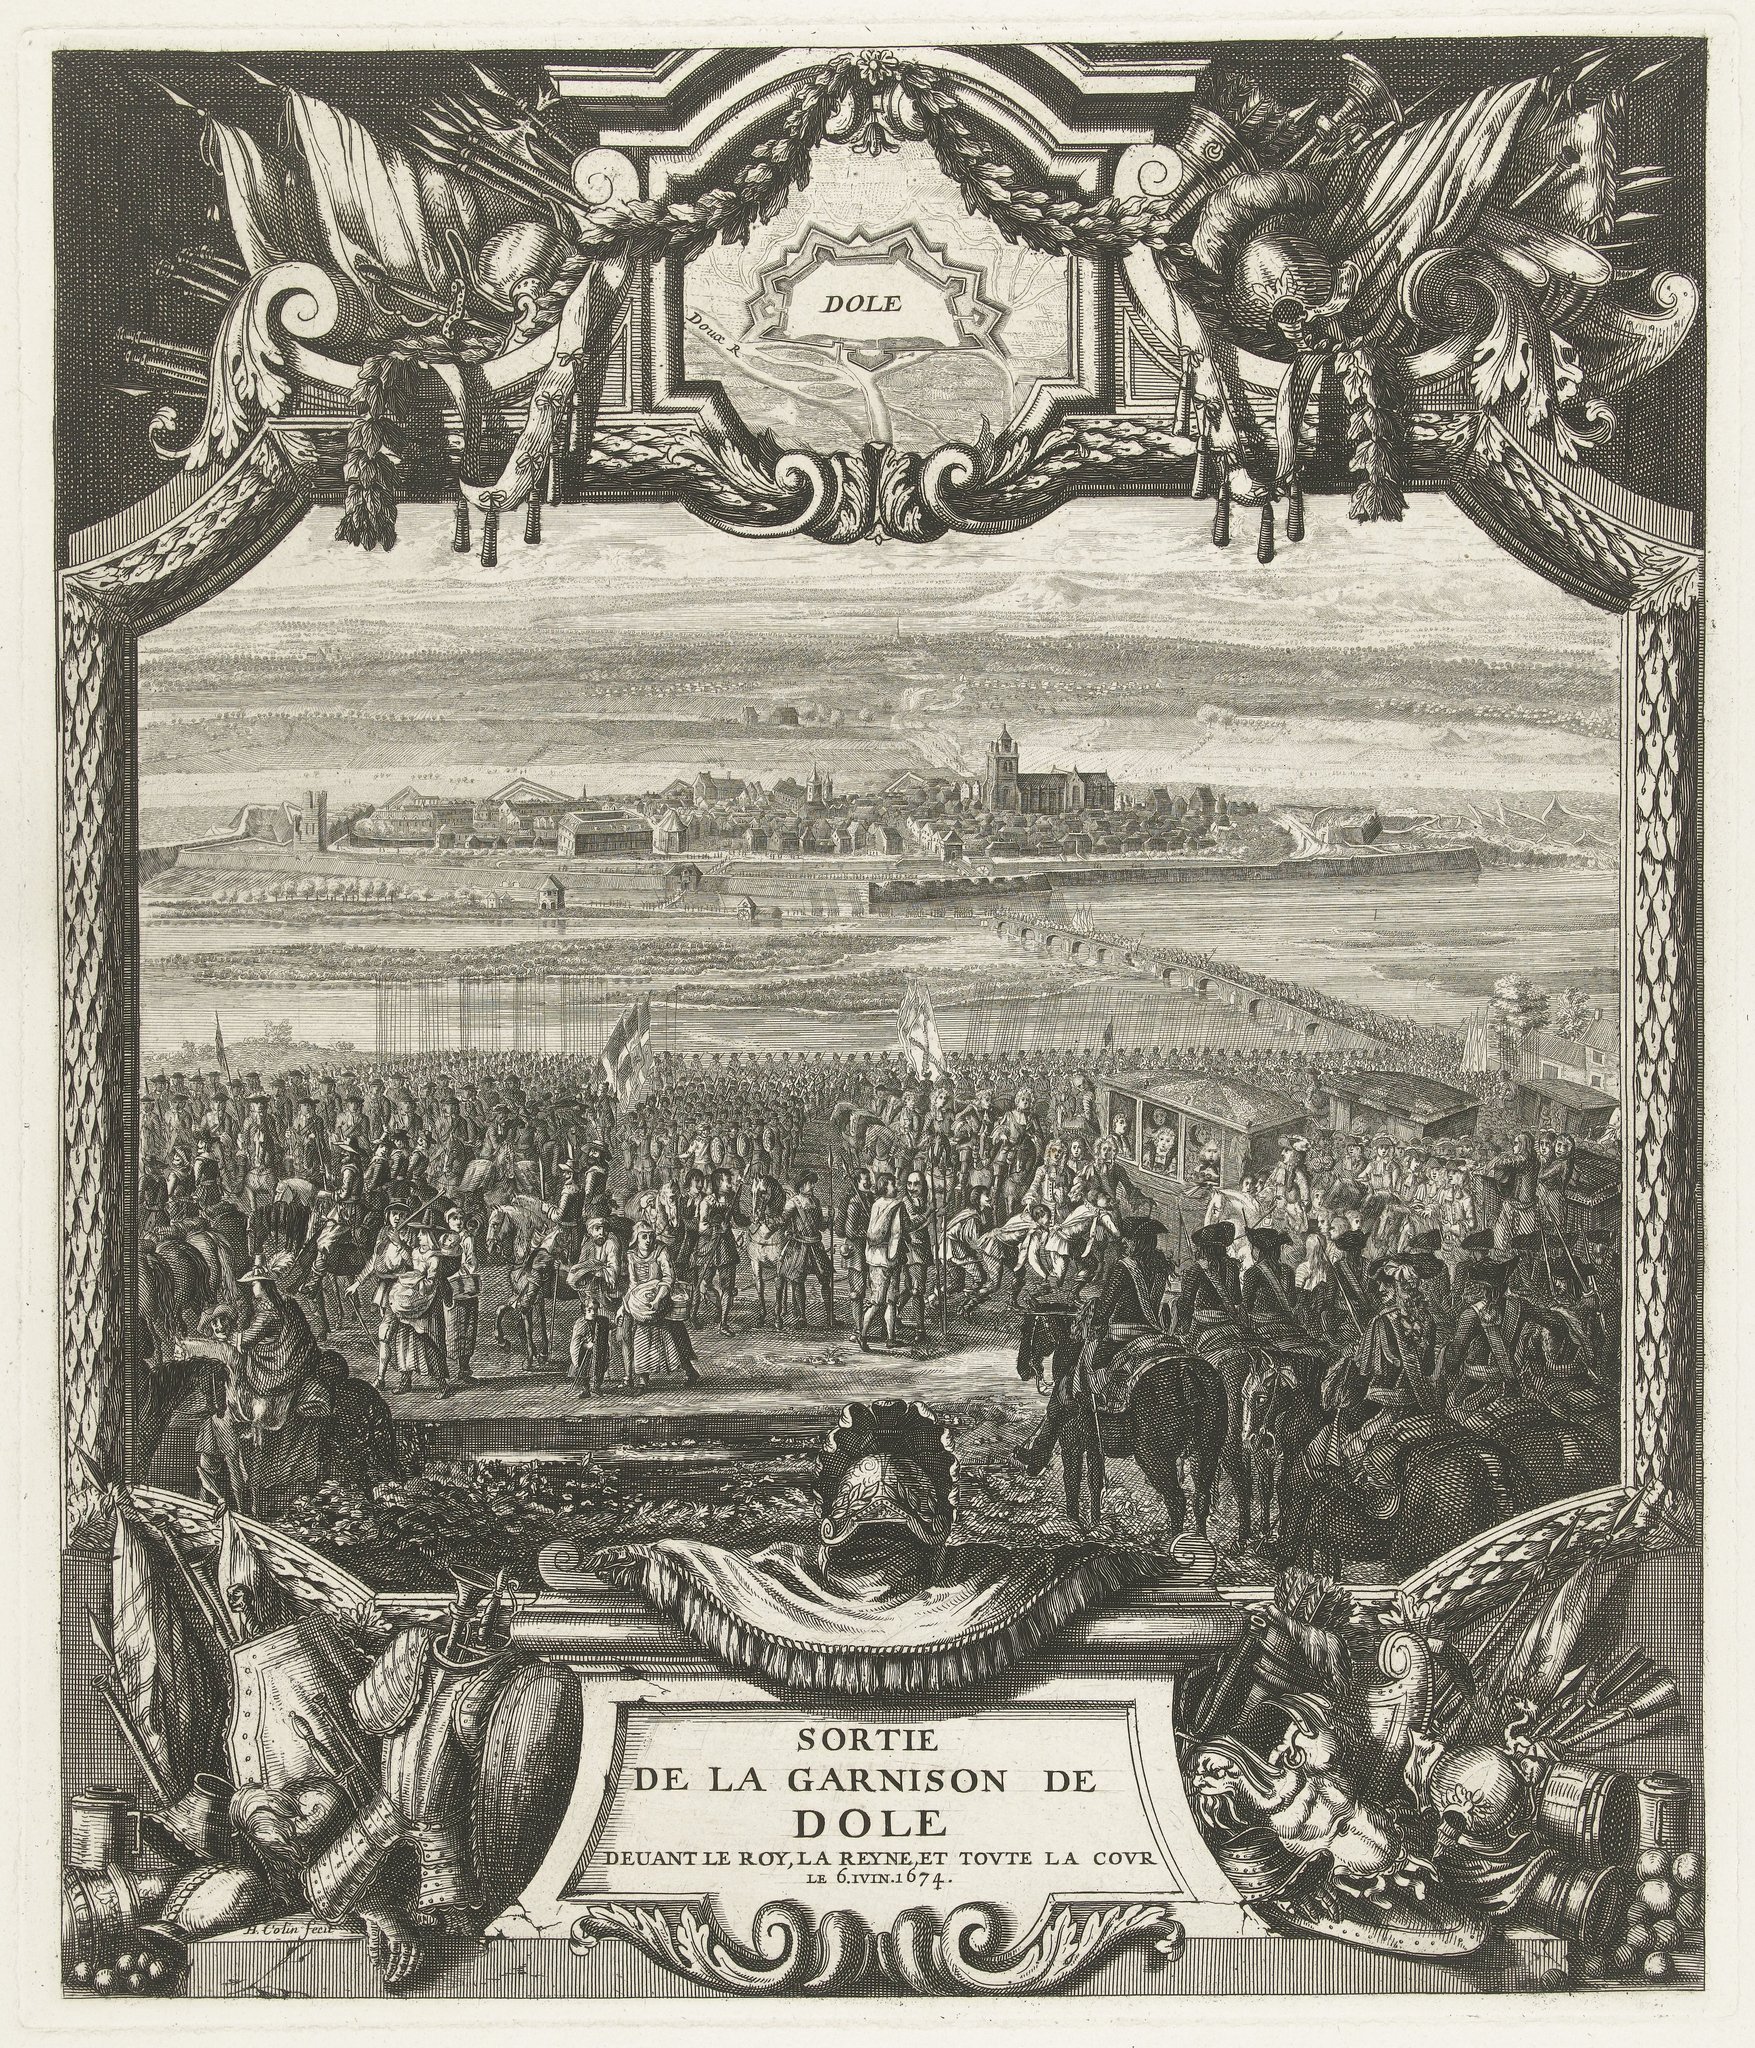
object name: print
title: Sortie de la garnison de Dole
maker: richard collin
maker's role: print maker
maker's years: 1627-1697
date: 1674-1676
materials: paper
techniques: engraving, etching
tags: lodewijk xiv (koning van frankrijk), capture of city (after the siege)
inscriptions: collector's mark: Lugt 2228, collector's mark: Lugt 1695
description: Gezicht op de stad Dole die ingenomen wordt door de Franse troepen onder Lodewijk XIV. Het leger trekt de stad binnen via een brug over de vestinggracht. Aan de overkant van de gracht staat een koets met Lodewijk XIV en zijn koningin. In een omlijsting met wapentuig en lauwerkransen. Boven de voorstelling een cartouche met de omtrek van de vestingstad Dole en de loop van de rivier de Doubs.